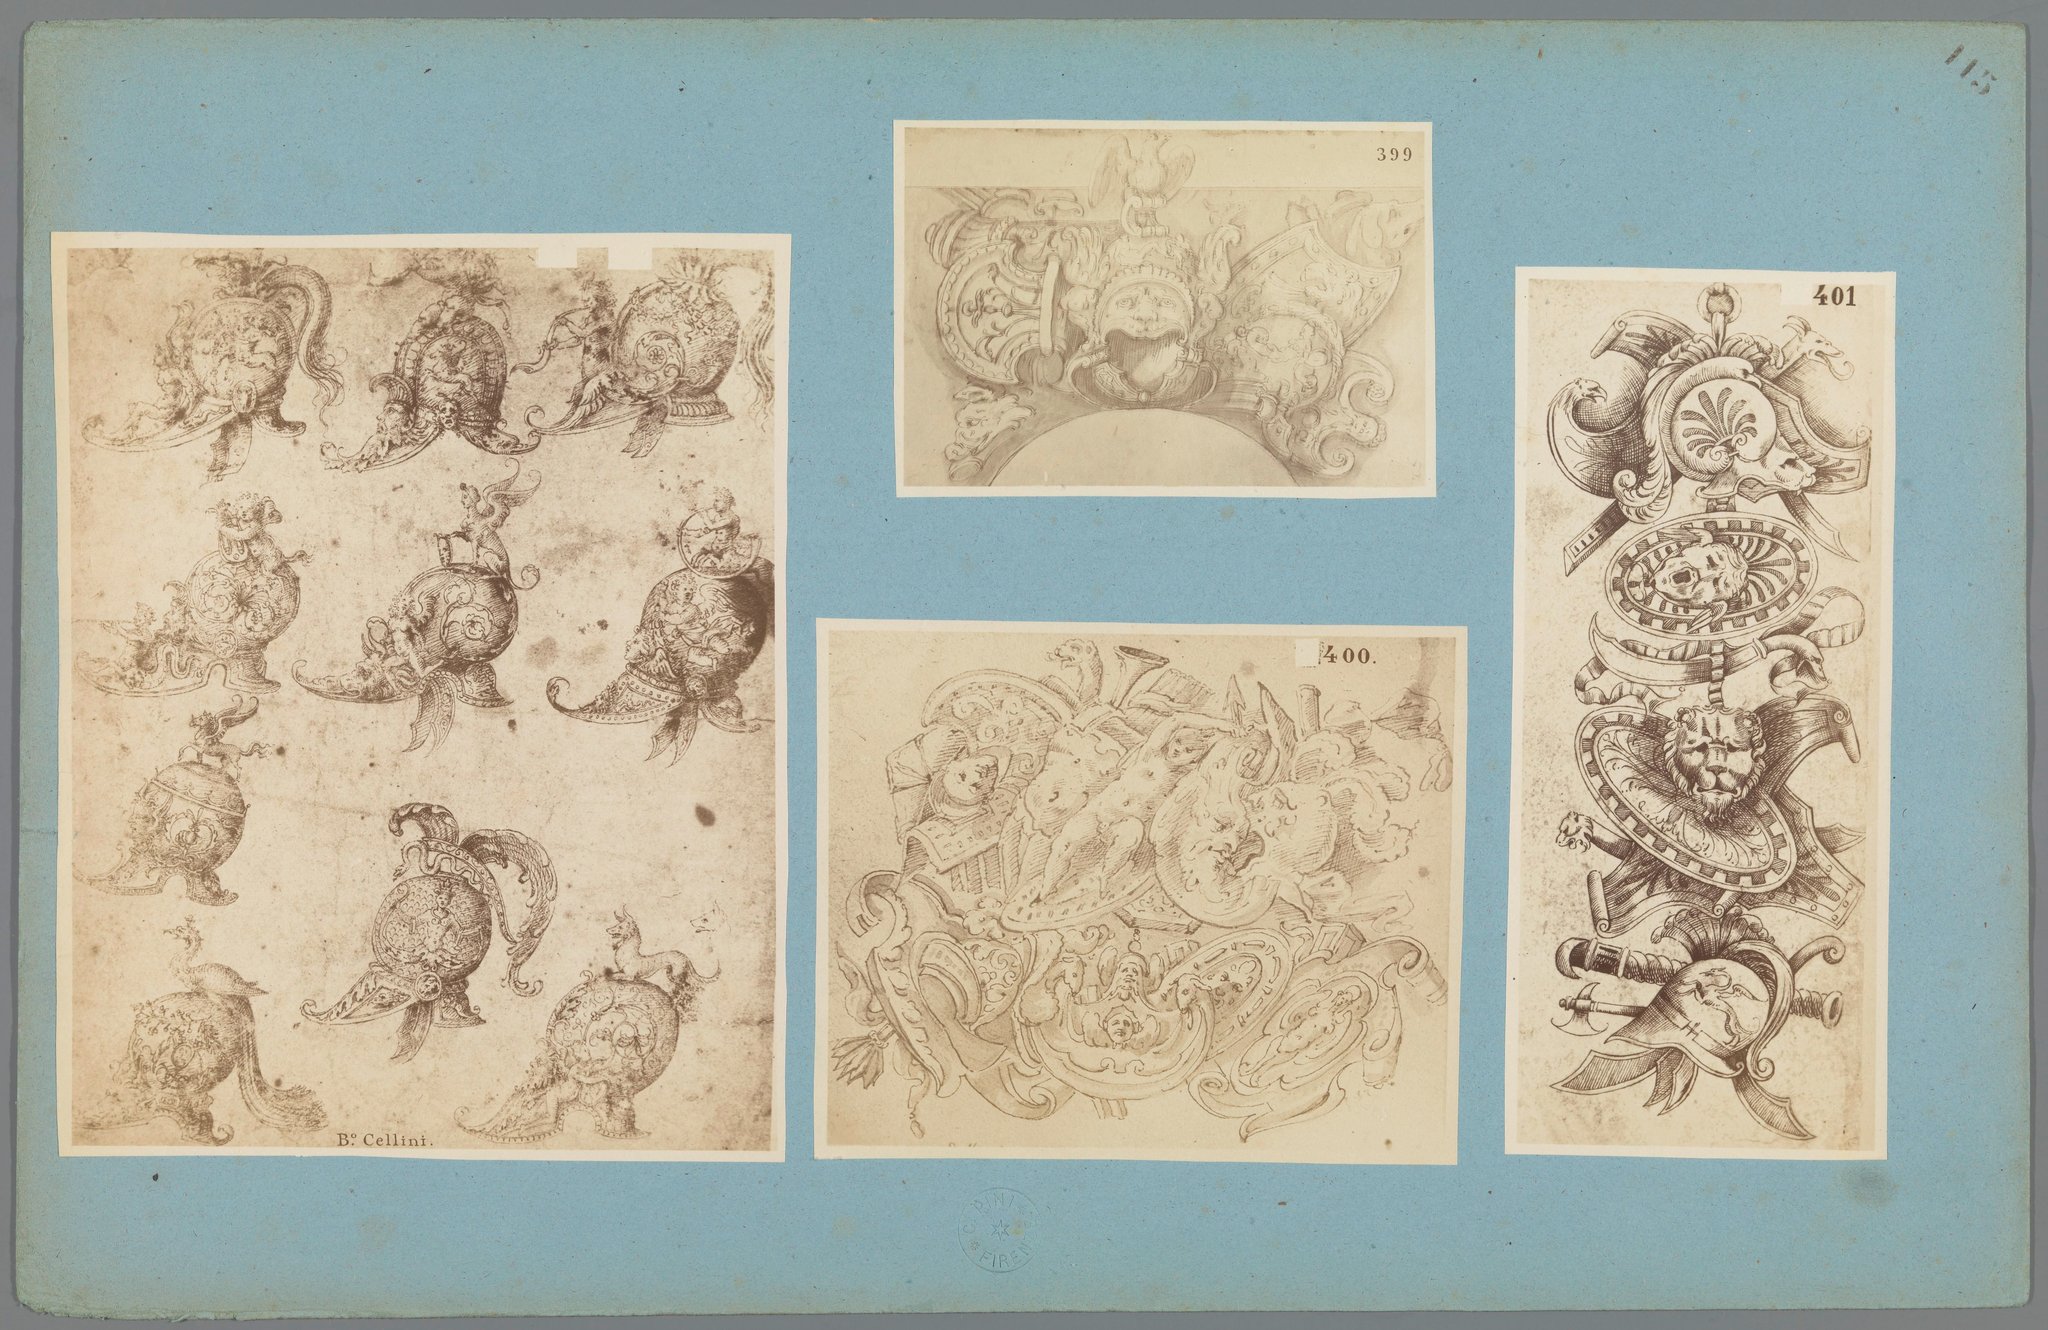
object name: photograph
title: Vier fotoreproducties van ornamentprenten en ornamenttekeningen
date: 1875-1900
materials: cardboard, photographic support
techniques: albumen print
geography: europe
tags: helmet, fantasy ornament, europe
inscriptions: collector's mark: Lugt 3937, name: ‘C. PINI FIRENZE’, number: ‘401’, number: ‘399’, number: ‘400.’, number: ‘115’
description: Links een prent van verschillende soorten helmen, middenboven (399) een tekening van fantasieornament voorstellende wapenuitrusting, middenonder (400) een tekening van fantasieornament betsaande uit wapenuitrusting en een putto, rechts (401) een prent van fantasieornament bestaande uit wapenuitrusting.